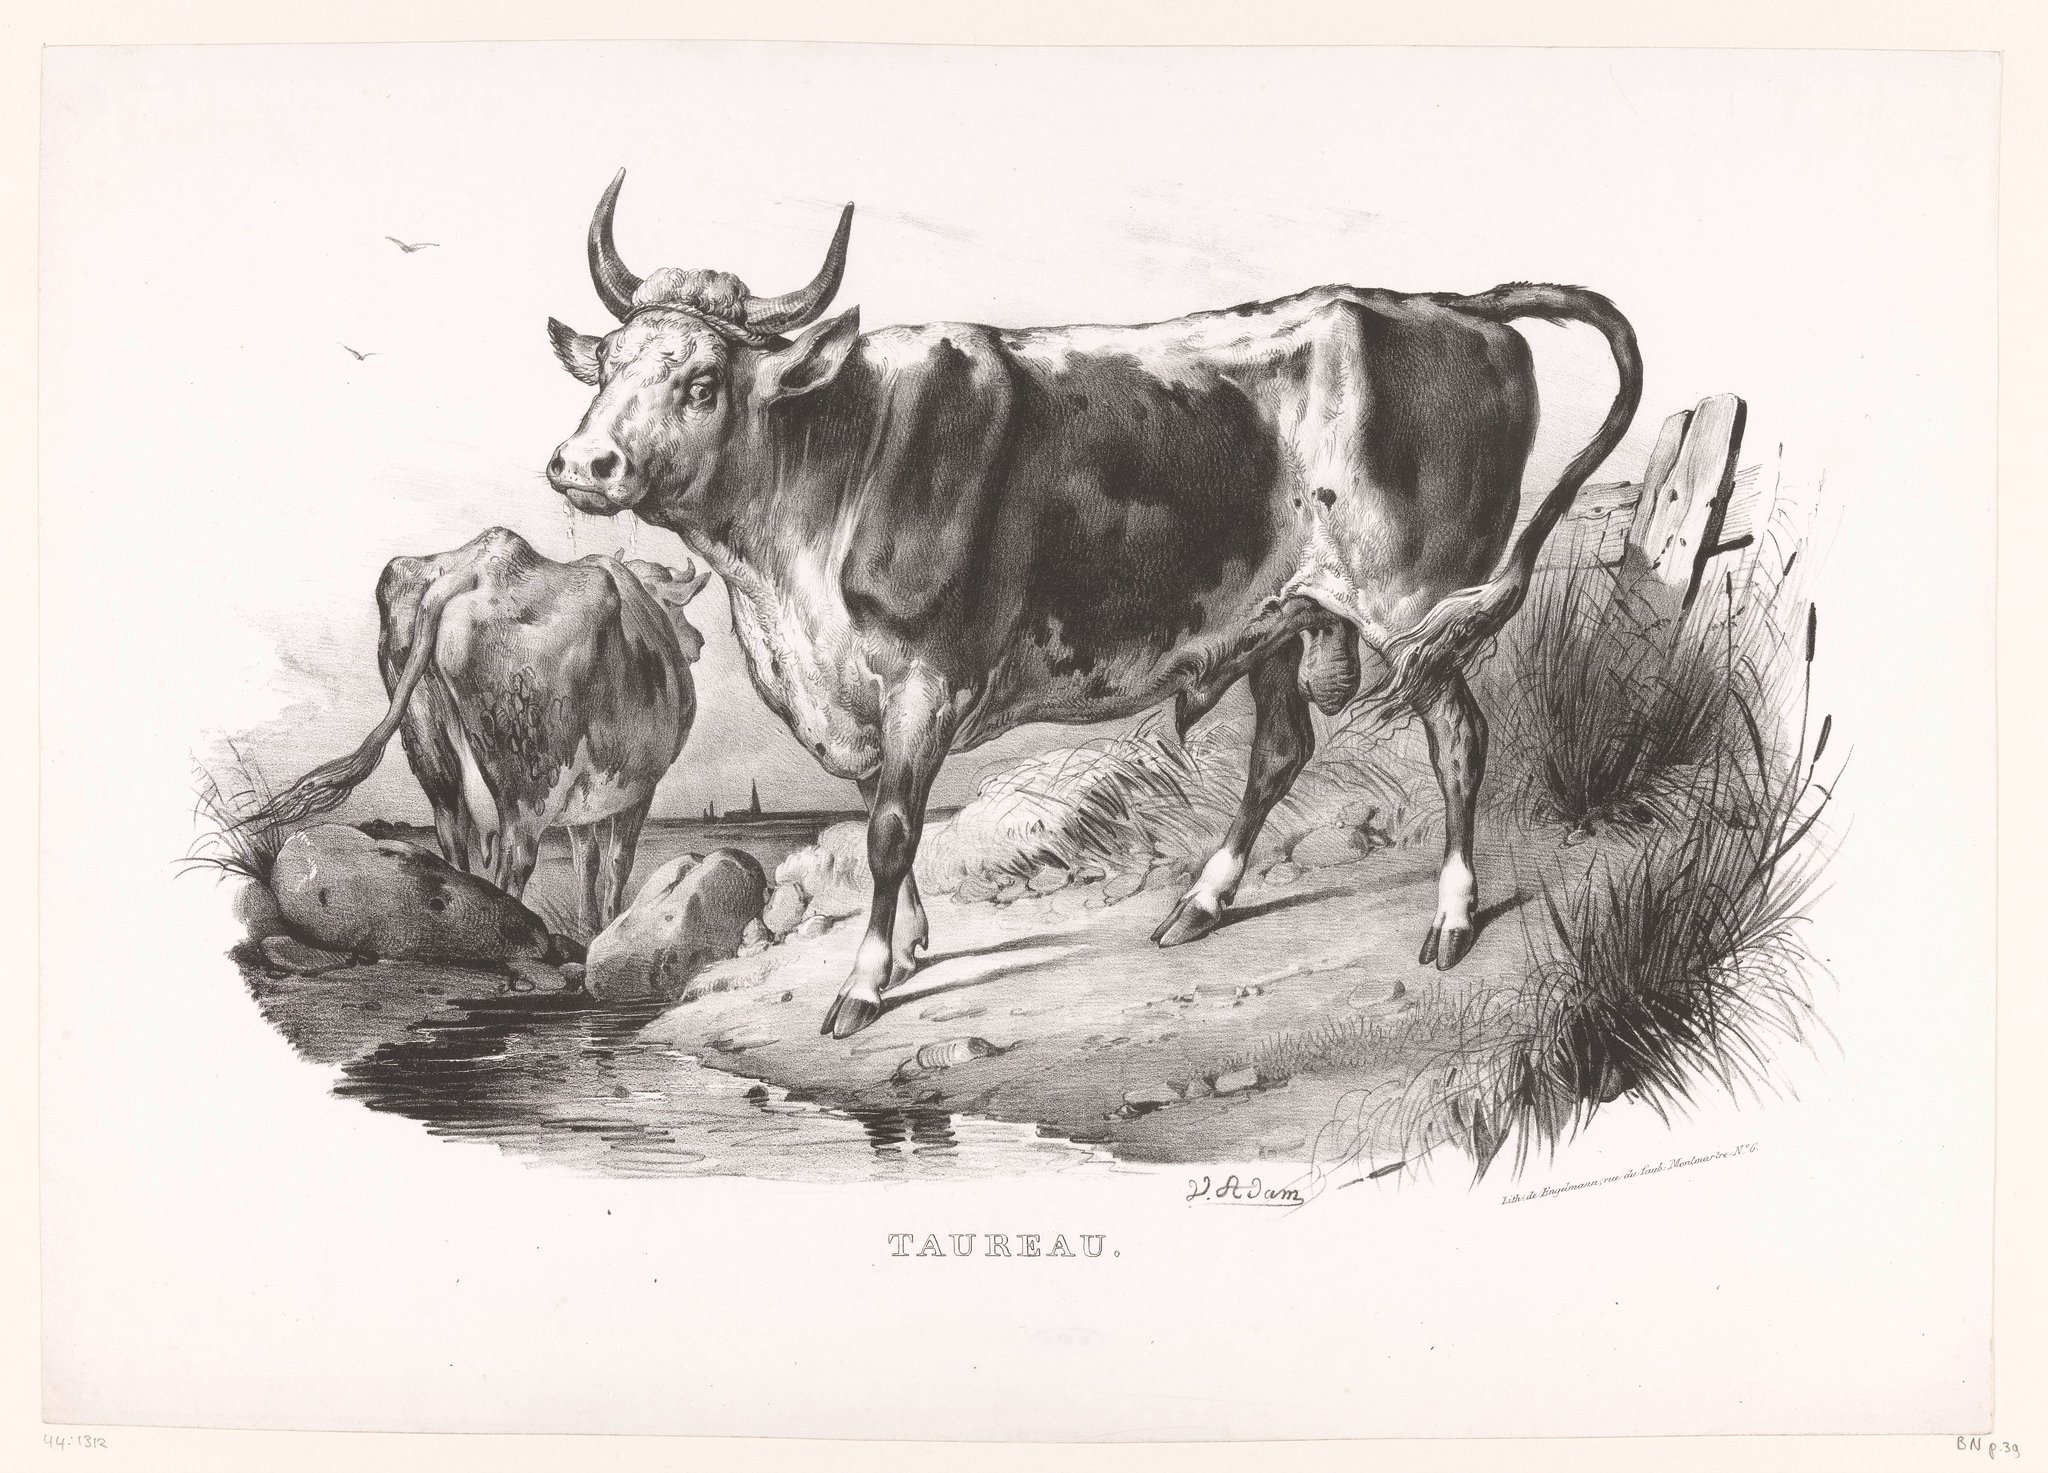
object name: print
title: Etudes de chevaux et autres animaux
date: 1829-1830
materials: paper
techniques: lithograph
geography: france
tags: bull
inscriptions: collector's mark: Lugt 2228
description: De prent is mogelijk de twintigste prent binnen een serie van 24 prenten.